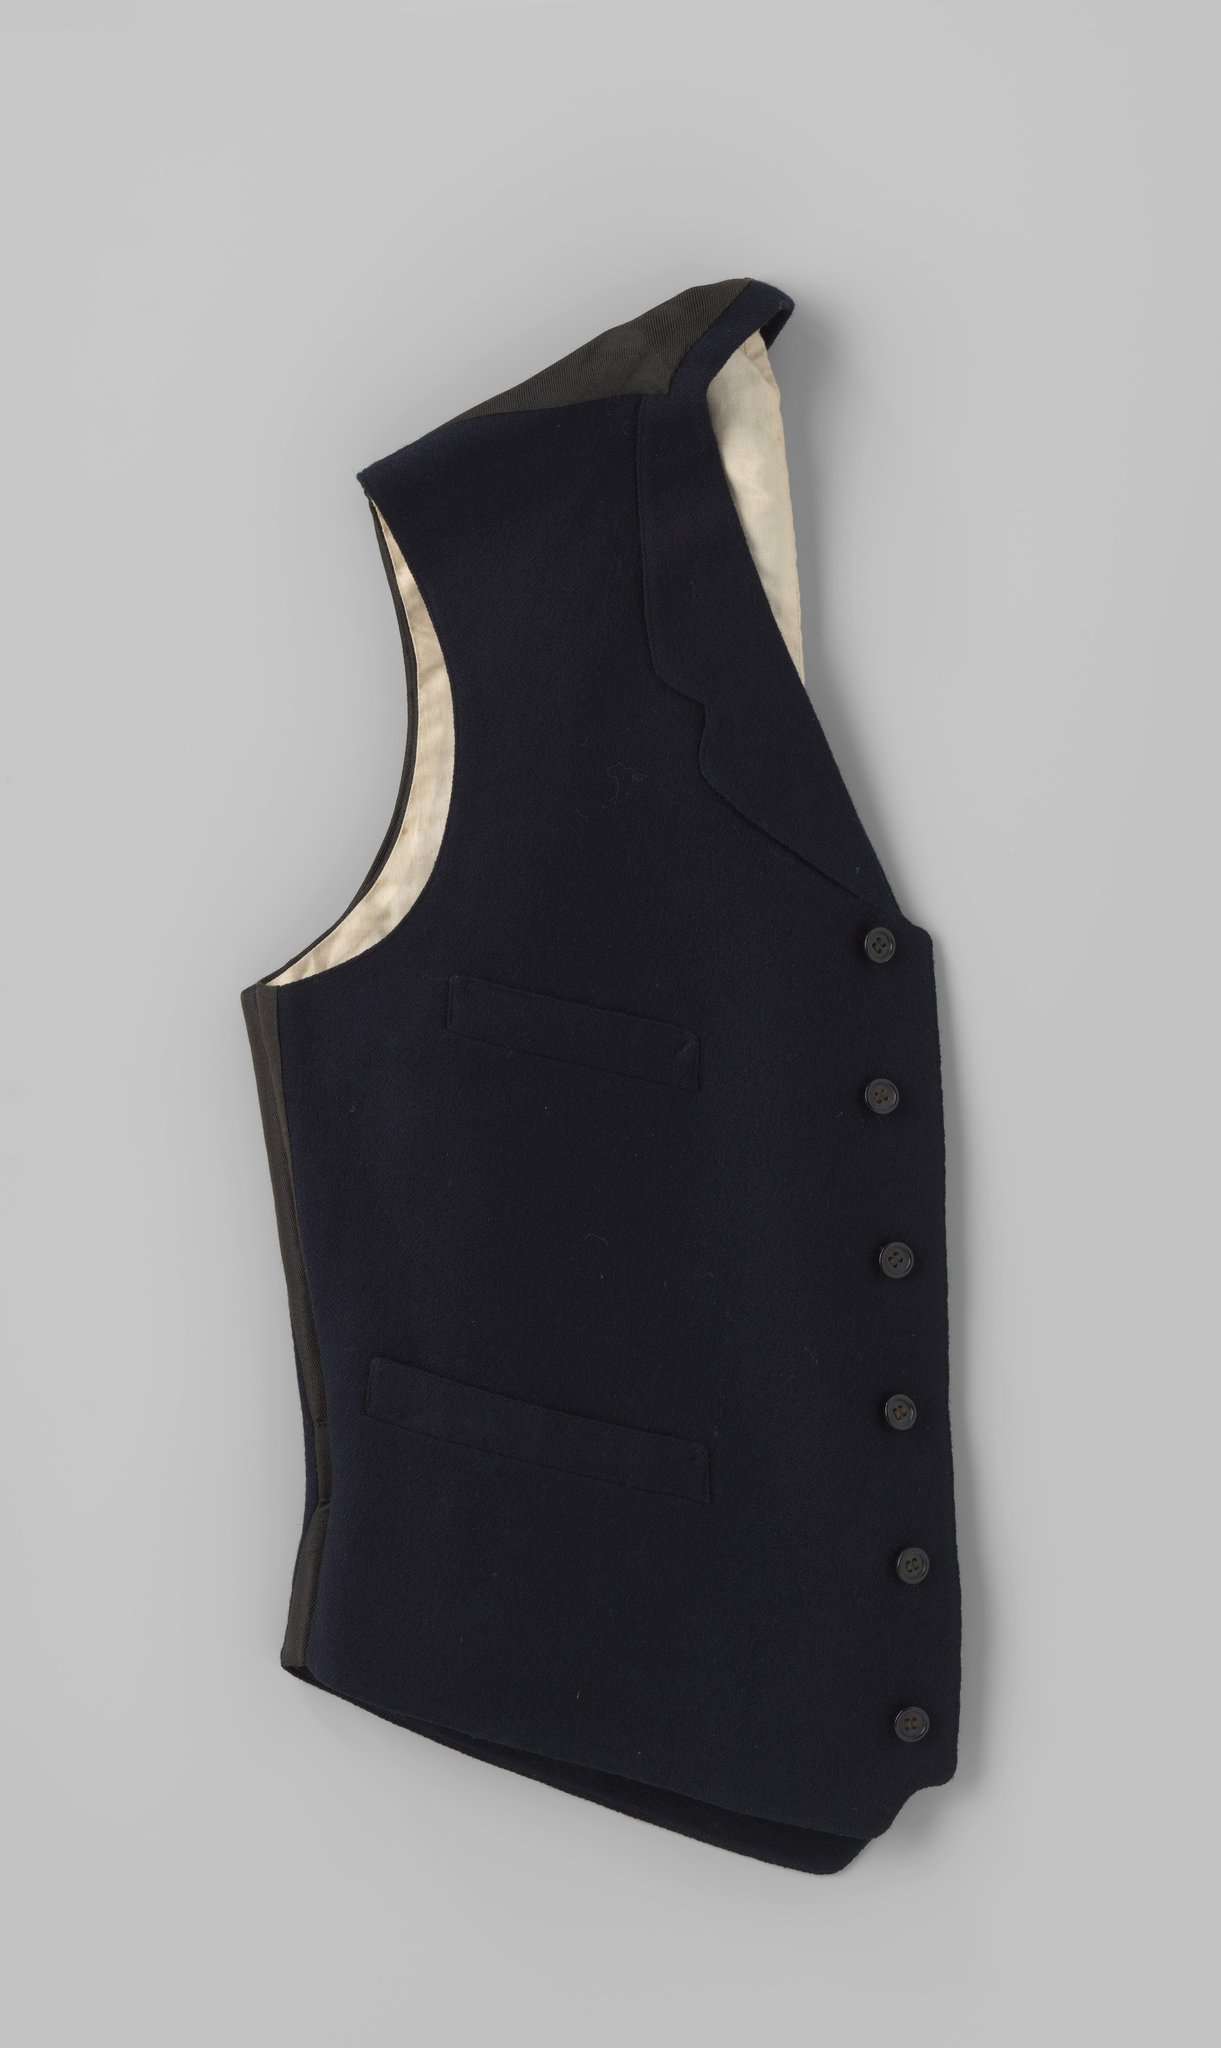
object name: main garment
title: Heren- of livreivest van donkerblauwe wol in keperbinding geweven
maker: Anonymous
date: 1910-1920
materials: wool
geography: the hague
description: Heren- of livreivest van donkerblauwe wol in keperbinding geweven. Vest met hoge V-hals met kraagje met revers. Panden met kleine V-punten. Zes zwart benen knoopjes. Vier insteekzakjes. Voering van wit satinet.